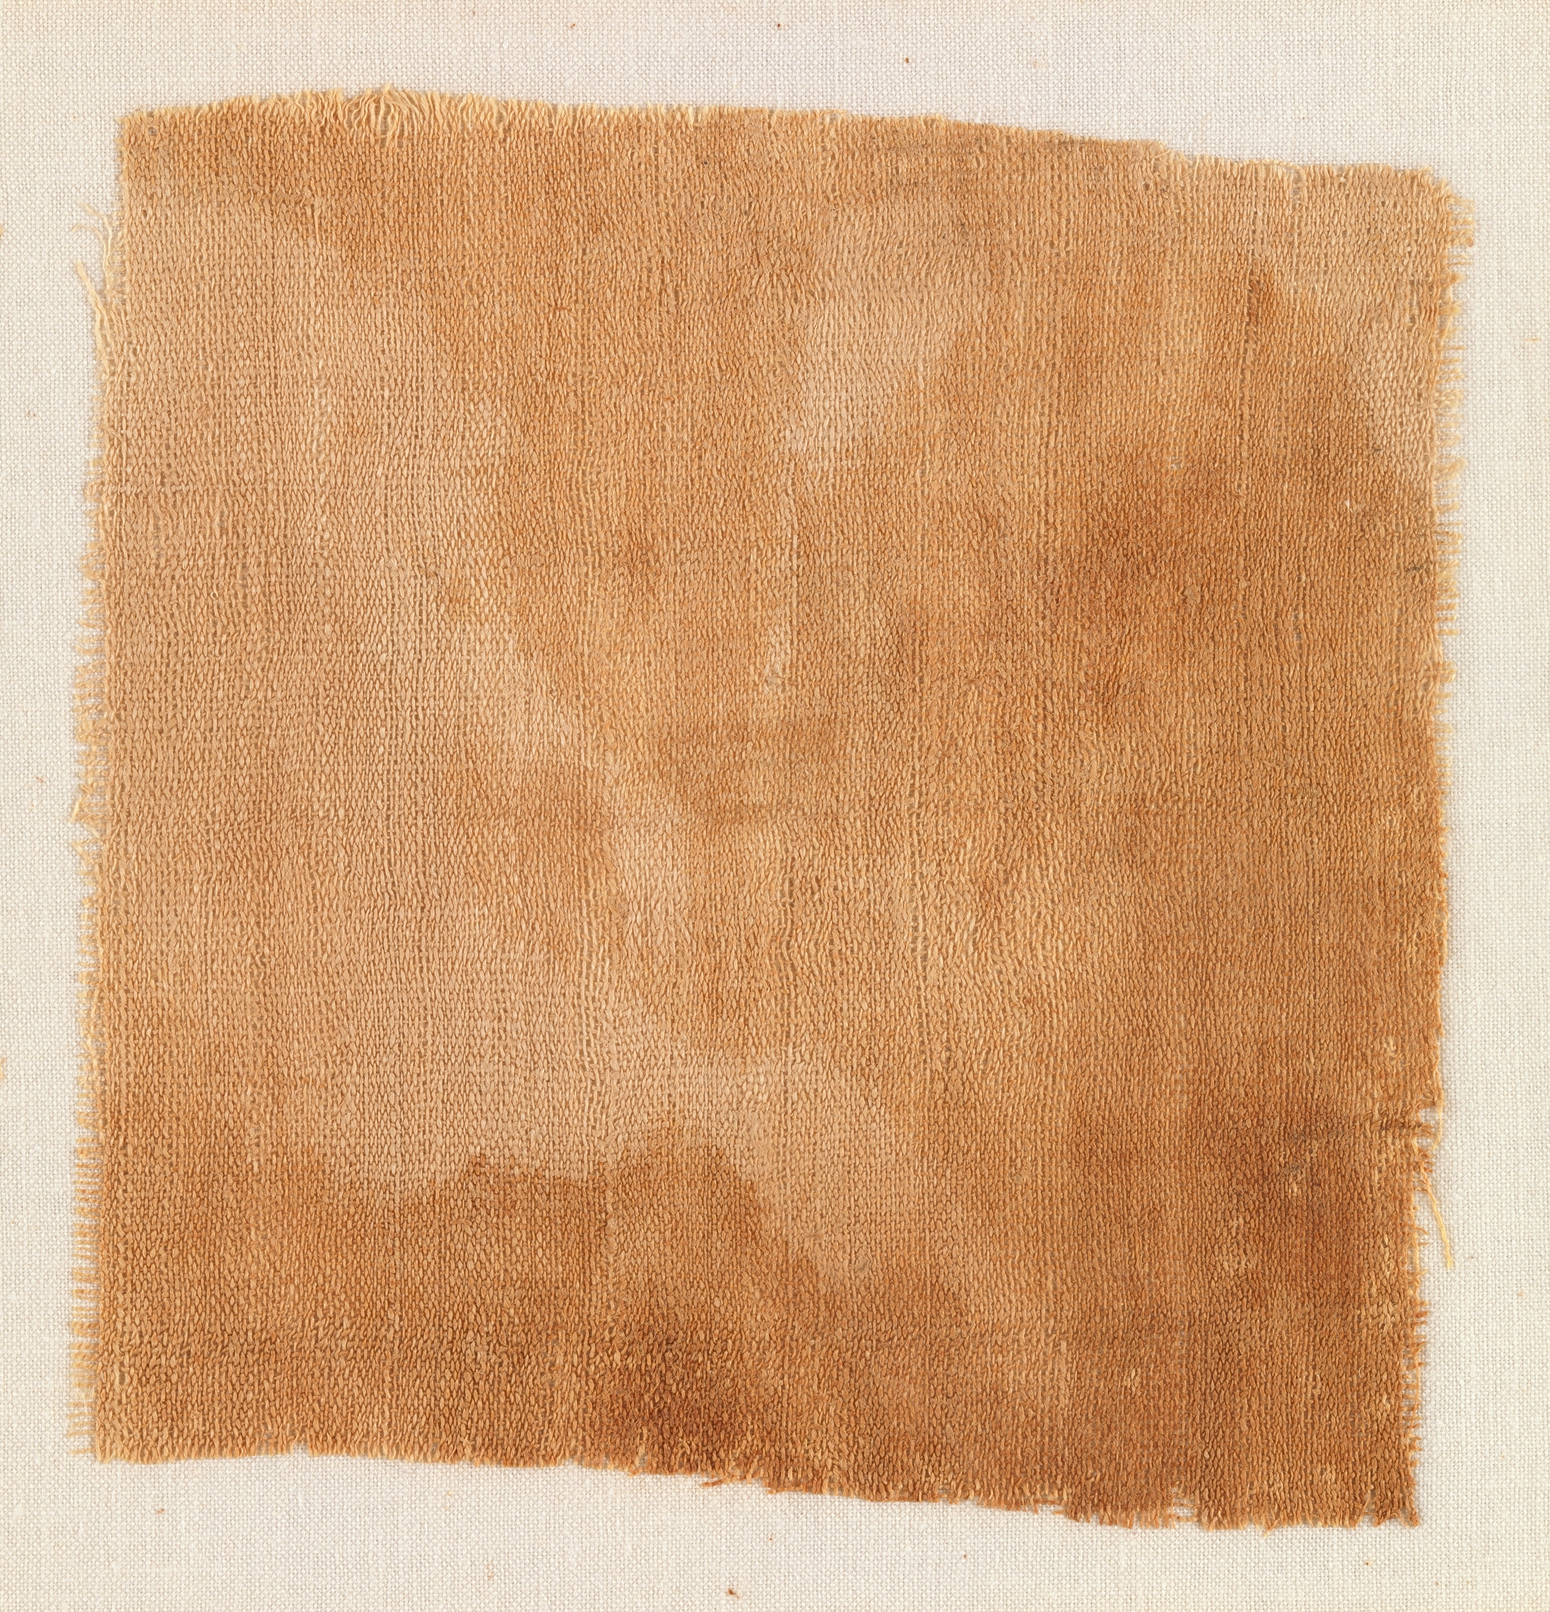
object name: linen sample, unis, mummy cloth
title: Sample of Cloth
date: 2353-2323 BCE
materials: linen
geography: egypt